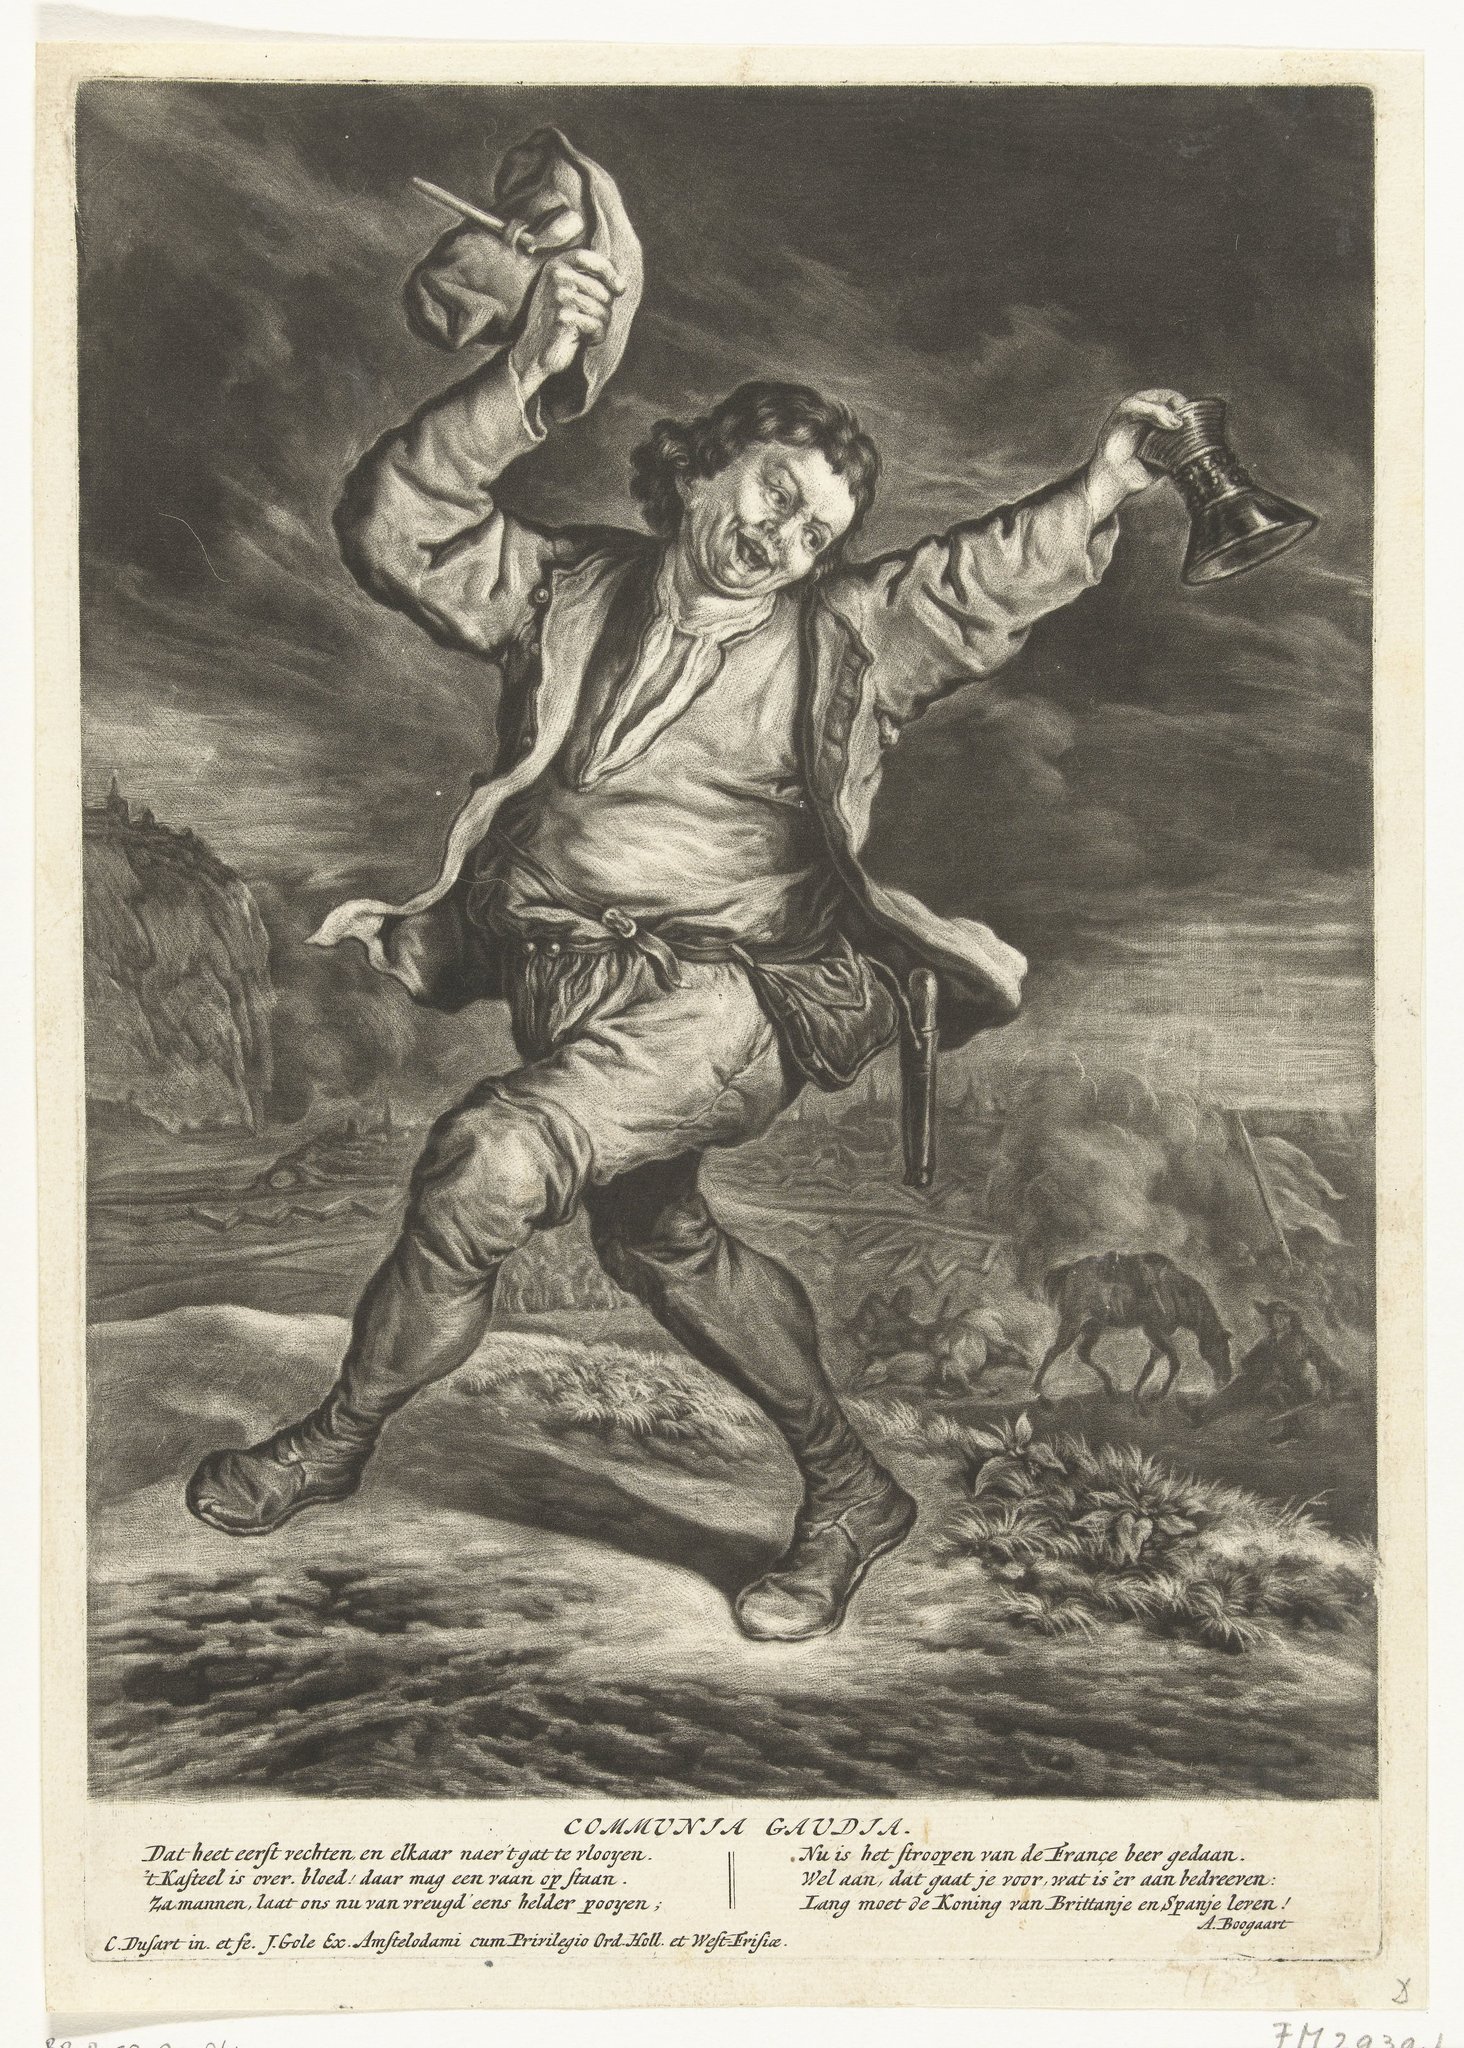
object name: print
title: Communia Gaudia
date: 1695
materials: paper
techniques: mezzotint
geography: amsterdam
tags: the hague, william iii (prince of orange and king of england, scotland, and ireland), festivities on events of national importance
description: De vrolijke patriot. Dansende man met een lege roemer en zijn hoed in zijn hand. Op de achtergrond de stad Namen en de vesting. Onder de voorstelling een Latijnse titel en een Nederlands vers van zes regels. Onderdeel van een reeks van acht prenten vervaardigd naar aanleiding van de verovering van Namen door de geallieerden op 5 september 1695.